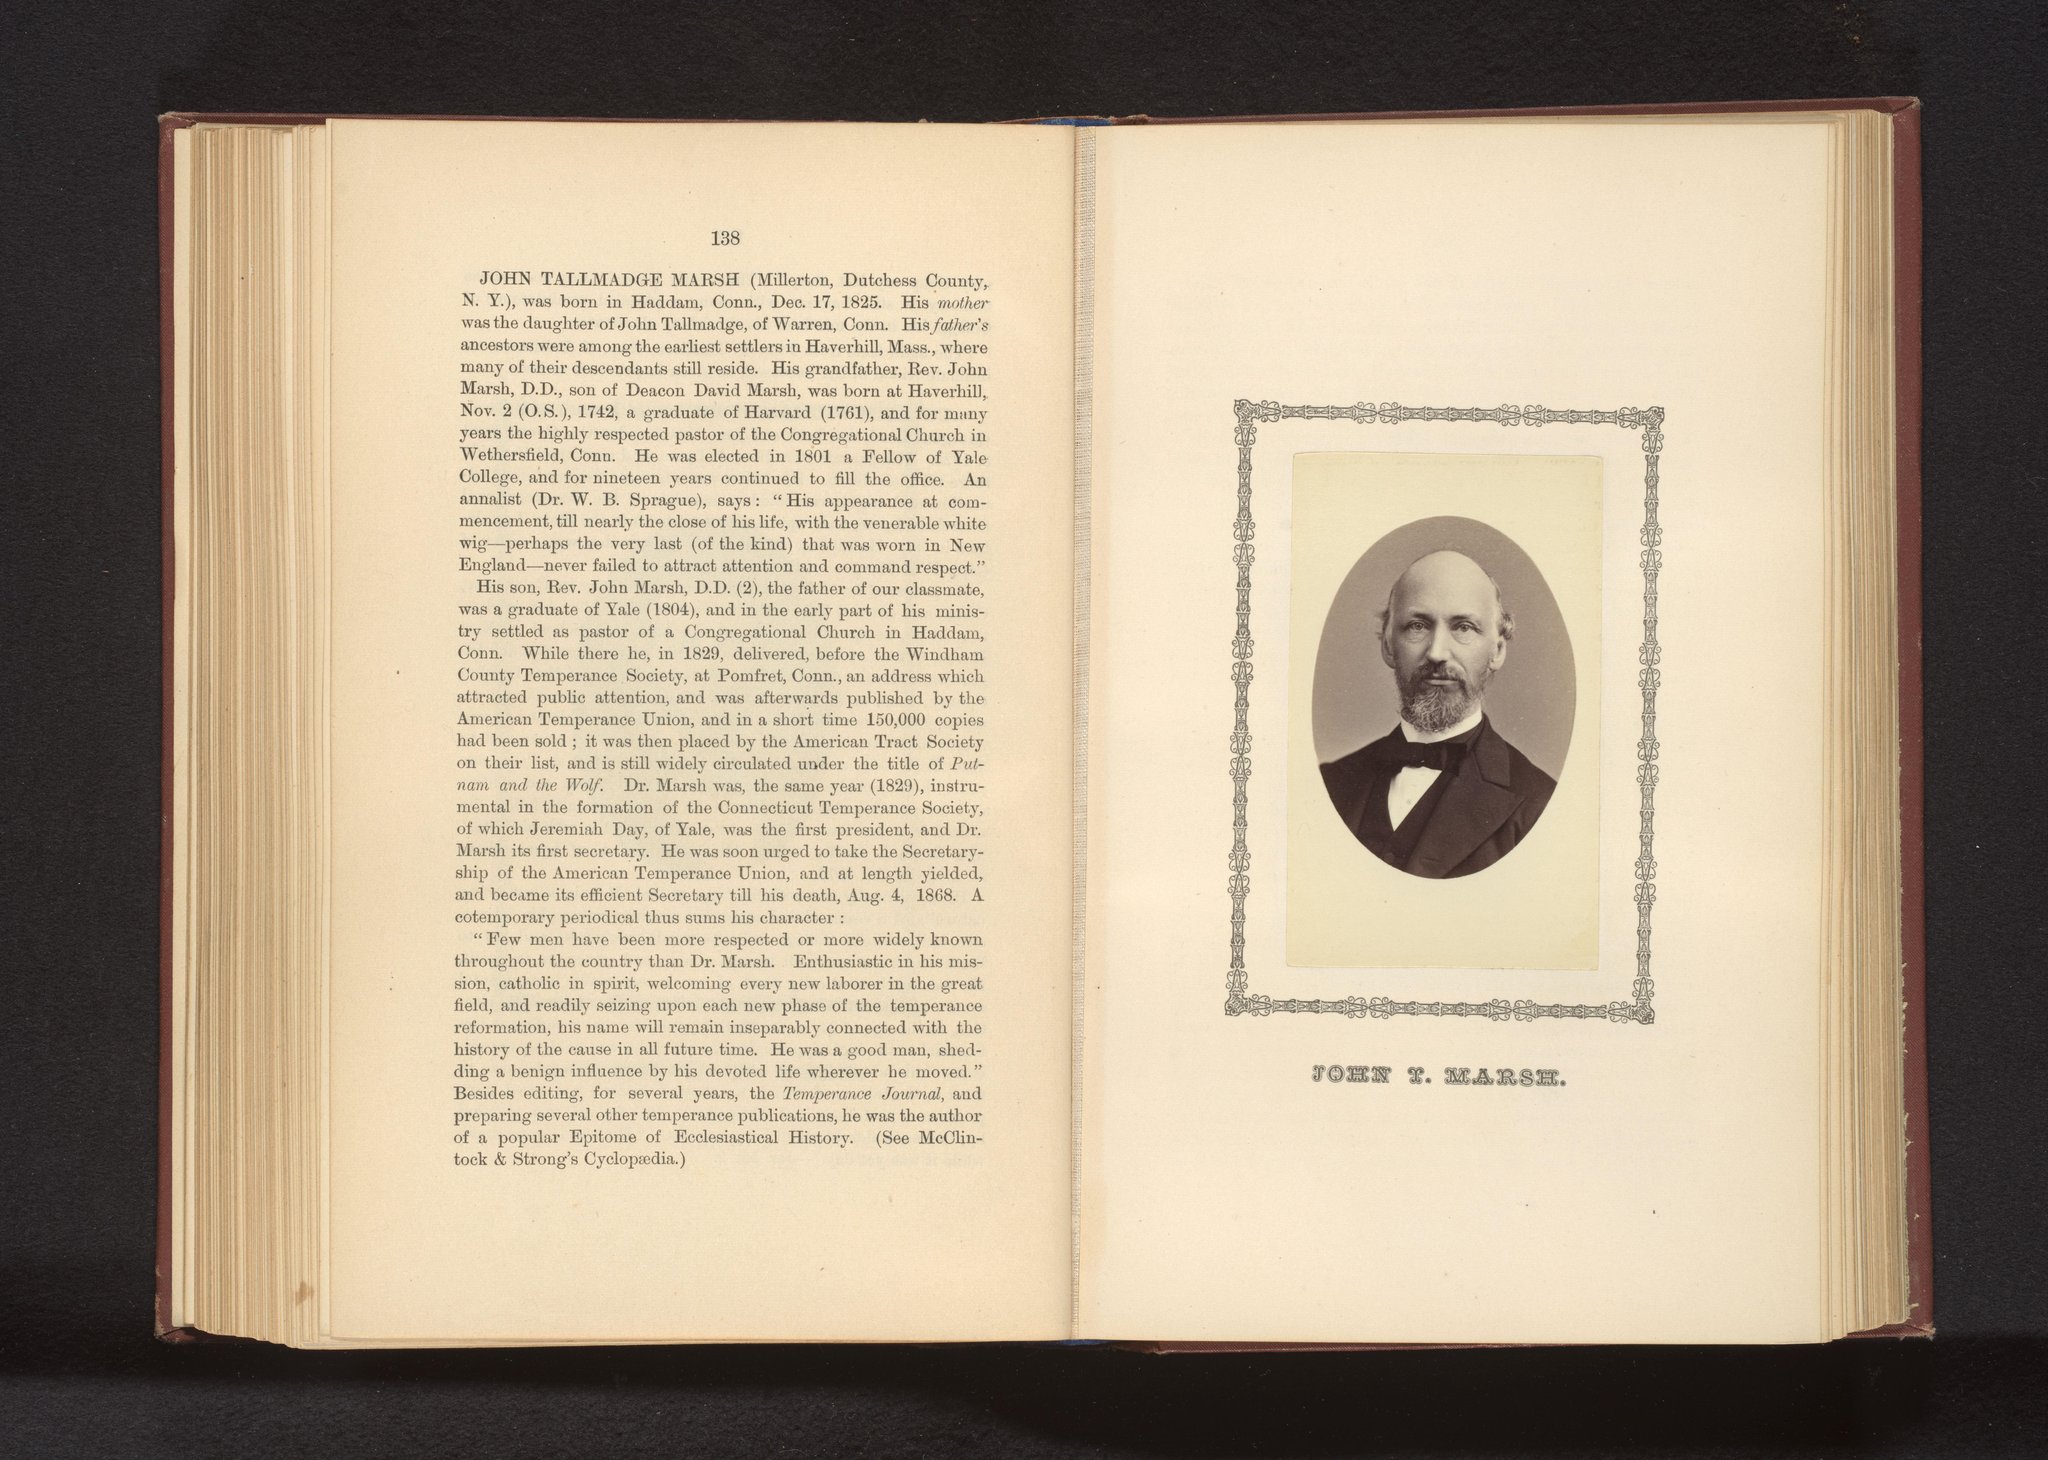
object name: photograph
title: John T. Marsh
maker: Anonymous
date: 1876-1881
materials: photographic support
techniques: albumen print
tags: adult man